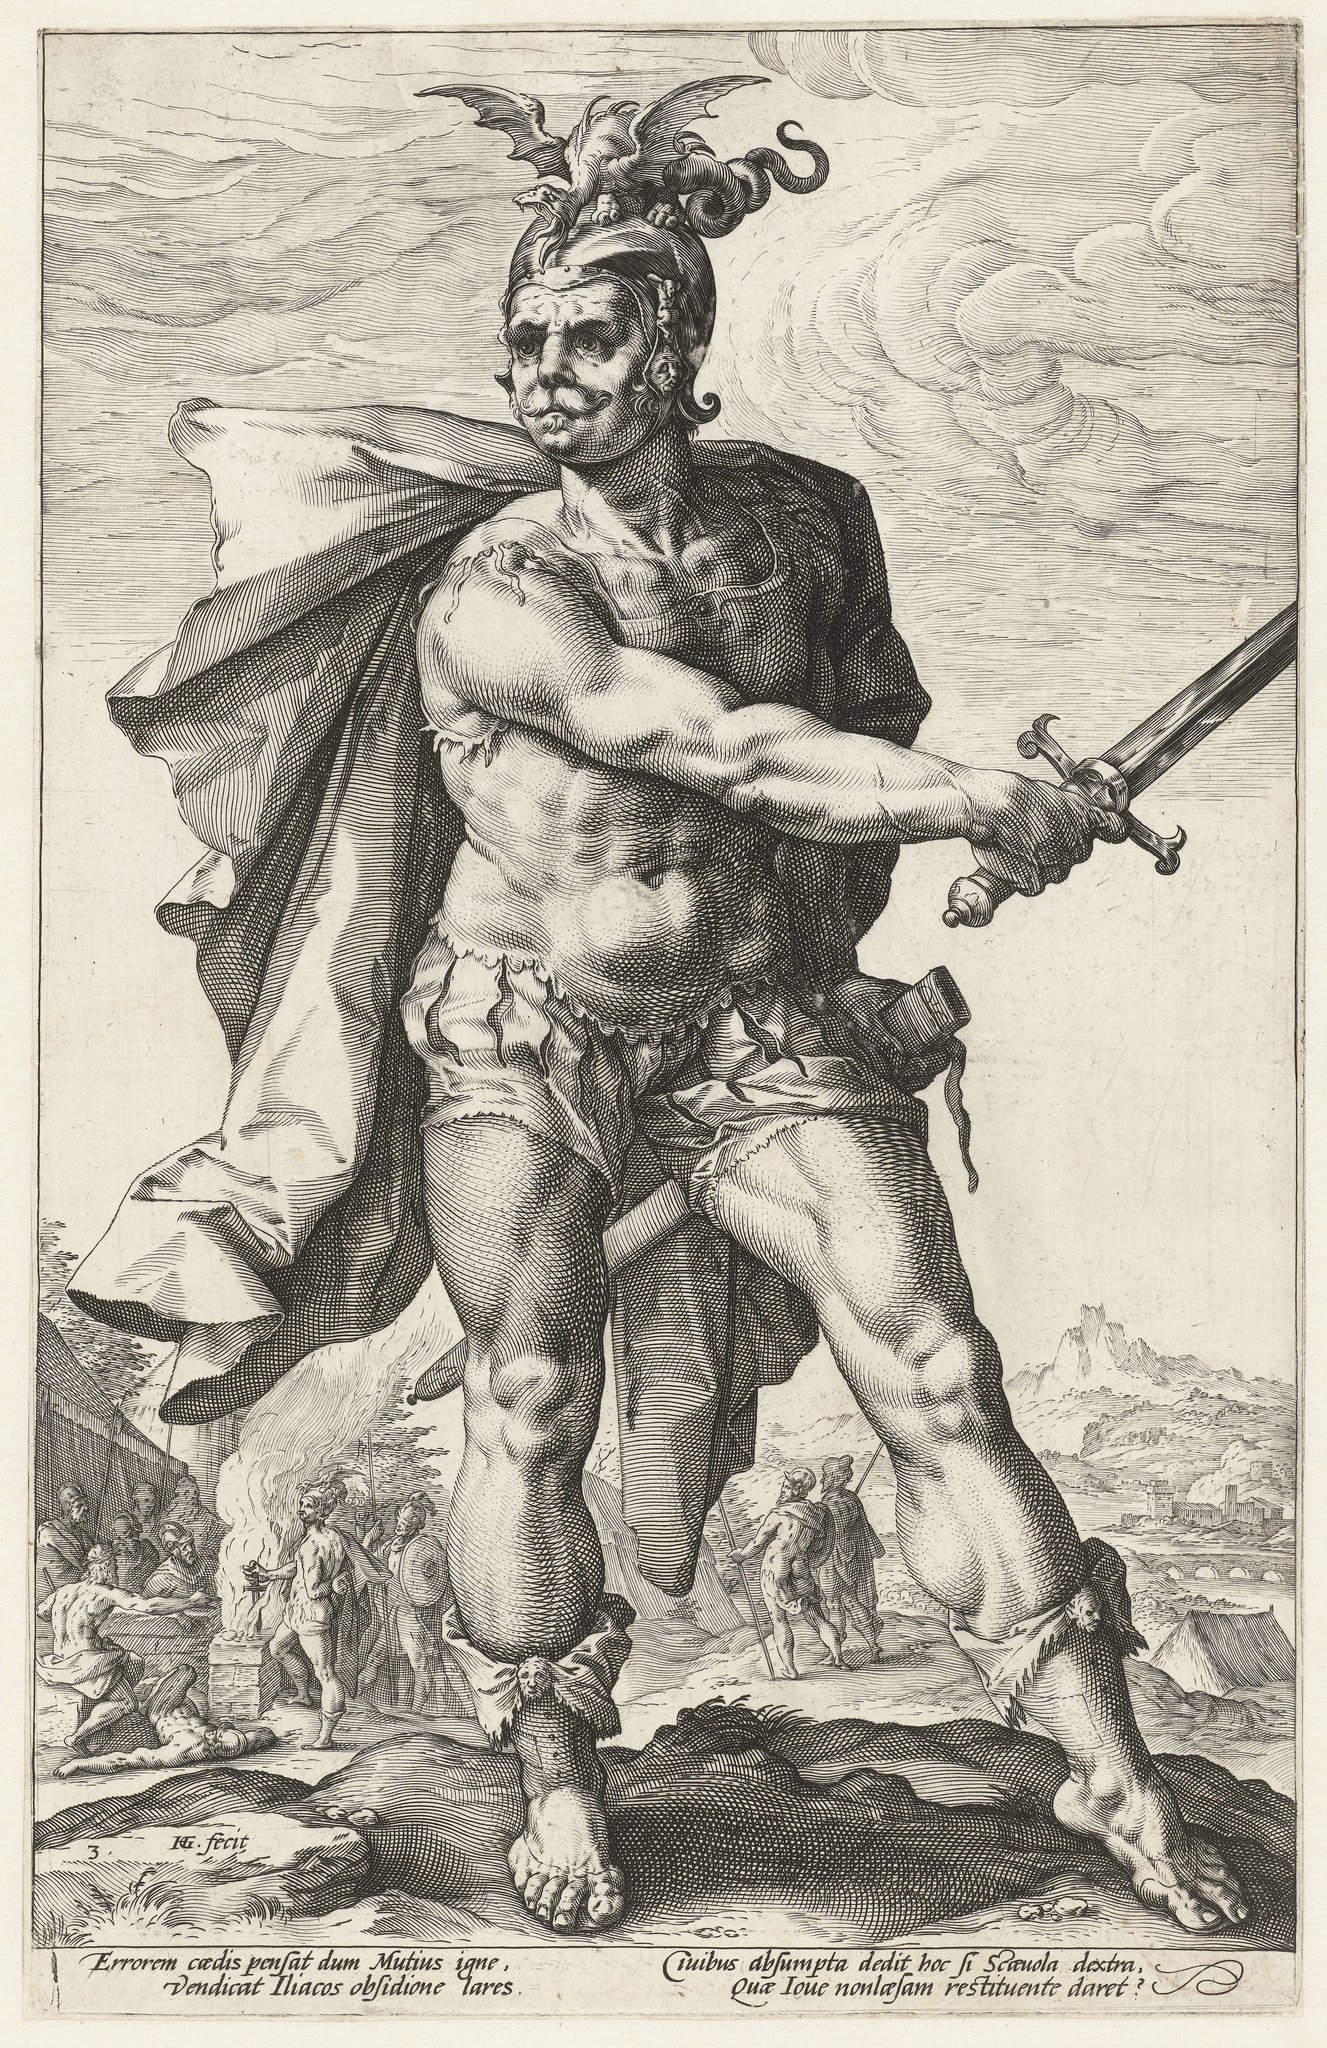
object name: print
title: De Romeinse helden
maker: hendrick goltzius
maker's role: draughtsman, painter, print maker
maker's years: 1558-1617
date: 1586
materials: paper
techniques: engraving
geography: haarlem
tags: gaius mucius scaevola before porsena: he thrusts his right hand into the flames (the body of the king's secretary who erroneously had been killed instead of porsena may be seen lying on the ground)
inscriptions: caption: ‘Errorem caedis...restituente daret.’, signature: ‘HG. fecit’, collector's mark: Lugt 240, number: ‘3’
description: De held Gaius Mucius Scaevola ten voeten uit, een zwaard in de rechterhand, de schede in de linkerhand. Op de achtergrond is te zien hoe hij zijn rechterhand voor koning Porsenna onverschrokken in het vuur steekt. Onder de voorstelling twee maal twee versregels in Latijn. Deze prent is onderdeel van een serie van tien prenten, bestaand uit een ongenummerde titelprent, acht genummerde voorstellingen van helden en een ongenummerde afsluitende prent.